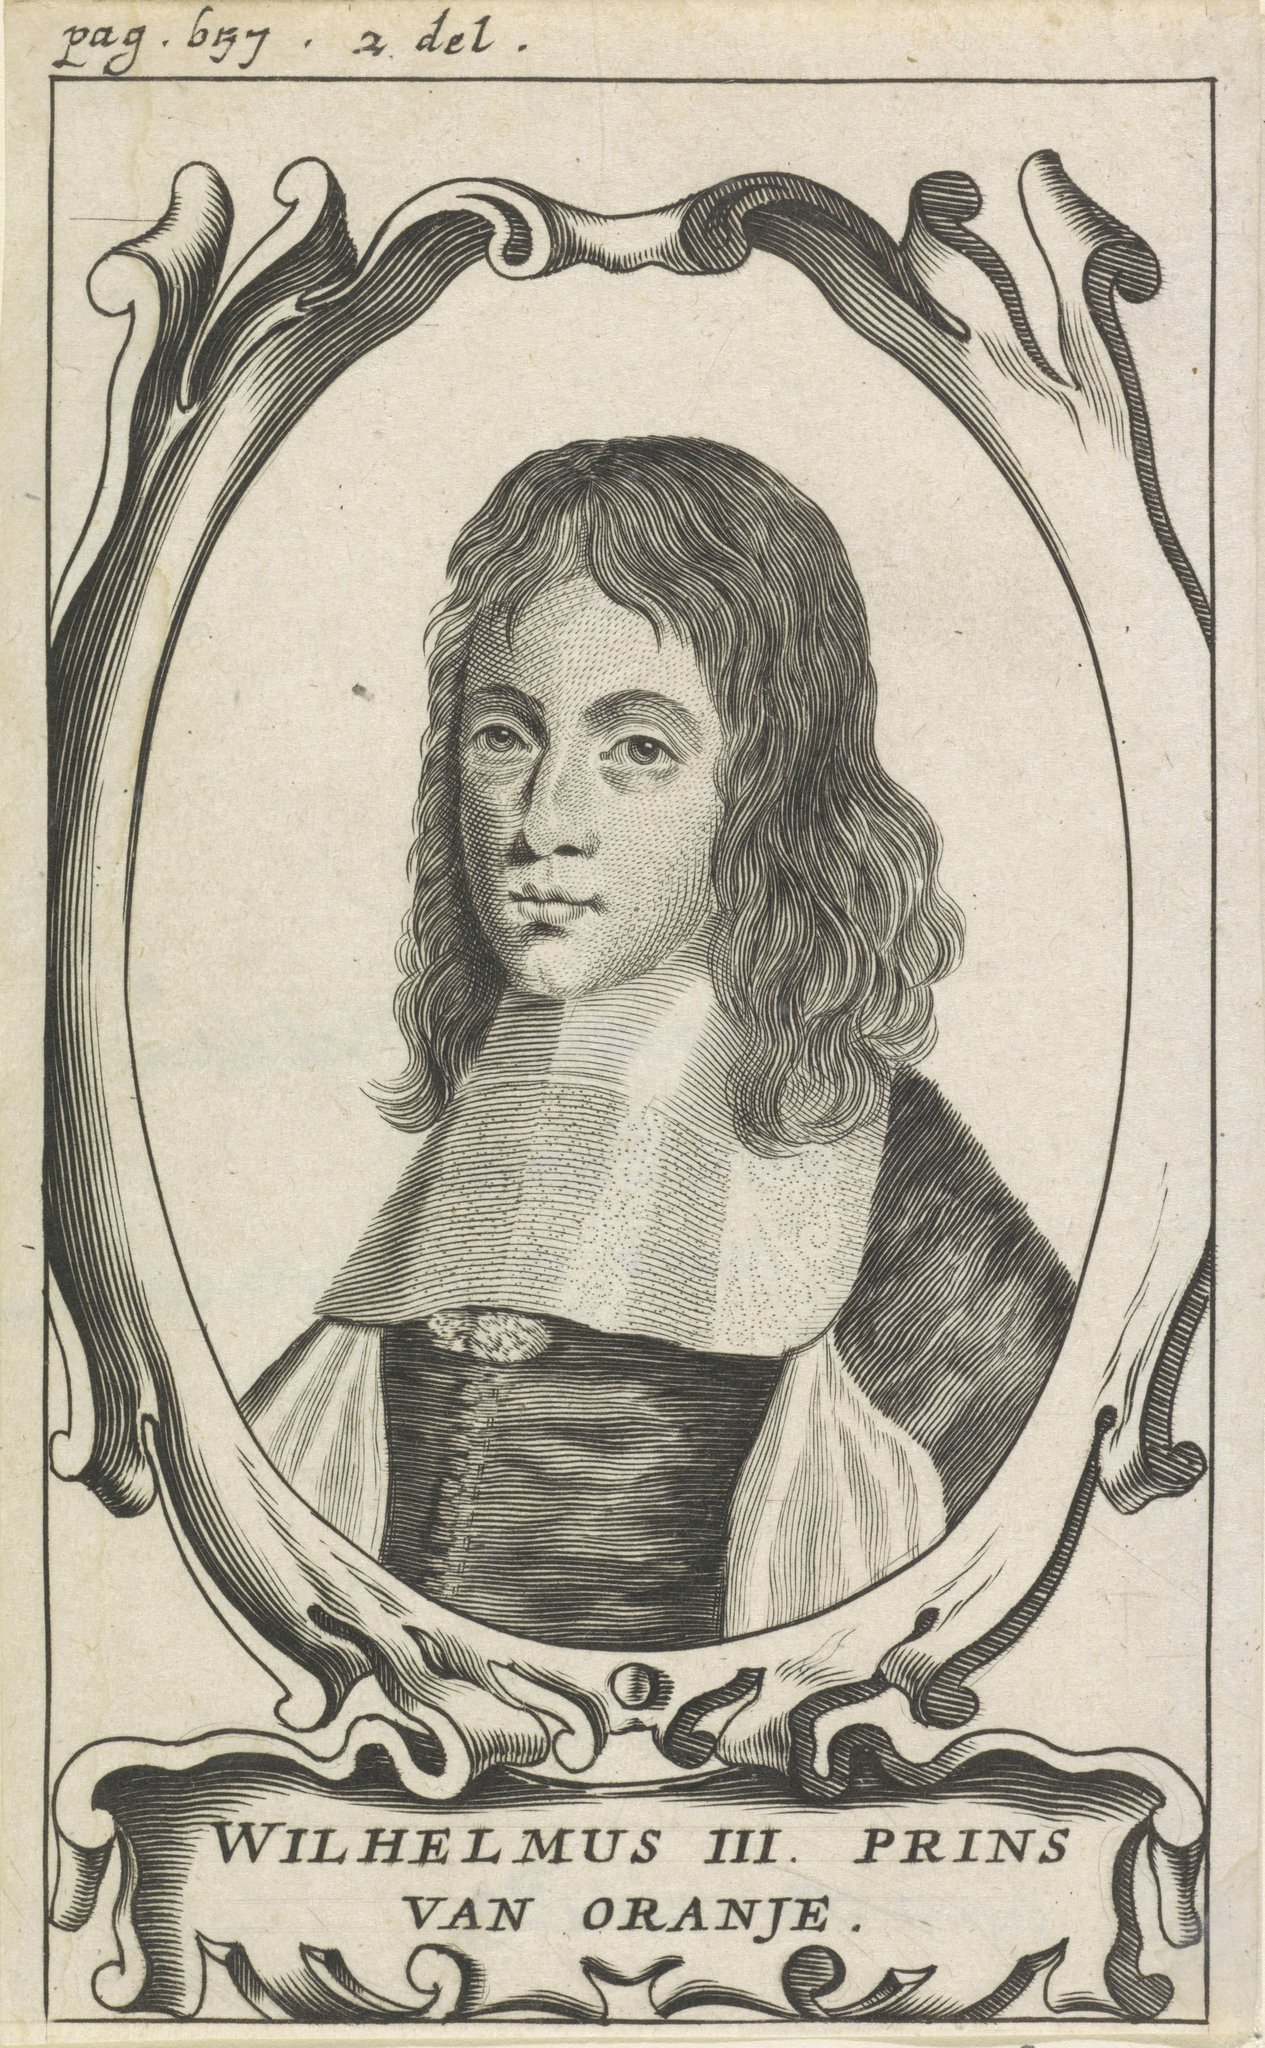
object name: print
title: Portret van Willem III, prins van Oranje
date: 1663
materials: paper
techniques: engraving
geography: low countries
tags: the hague, william iii (prince of orange and king of england, scotland, and ireland)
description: De hier vermelde titel verwijst naar de hoogst verkregen titel van de geportretteerde, niet per se naar de titel die de geportretteerde op deze voorstelling draagt. Prent uit: Nassouser heldens pronk-toonneel opgetooydt, en volcierdt met de keurlĳkste helden van Nassou en Oranje. Amsterdam: Jacob van Meurs, 1663.